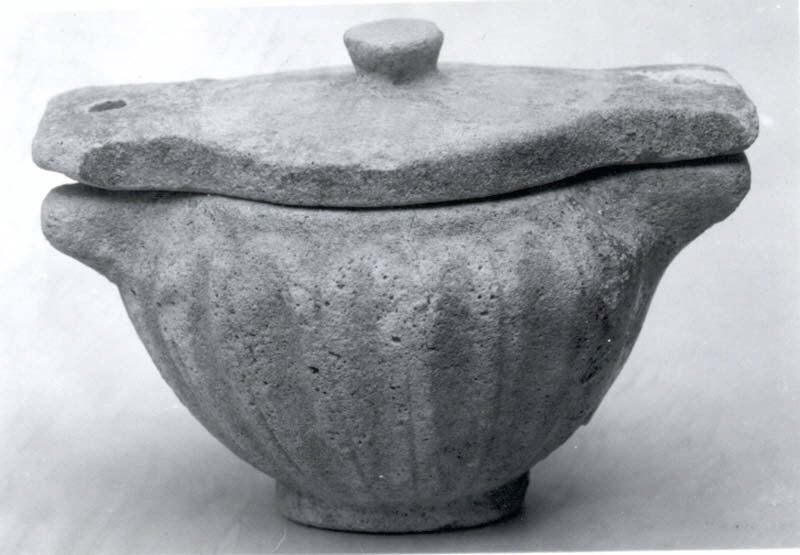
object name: jar with lid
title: Lidded jar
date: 1600-1101 BCE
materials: faience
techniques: glazing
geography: mesopotamia